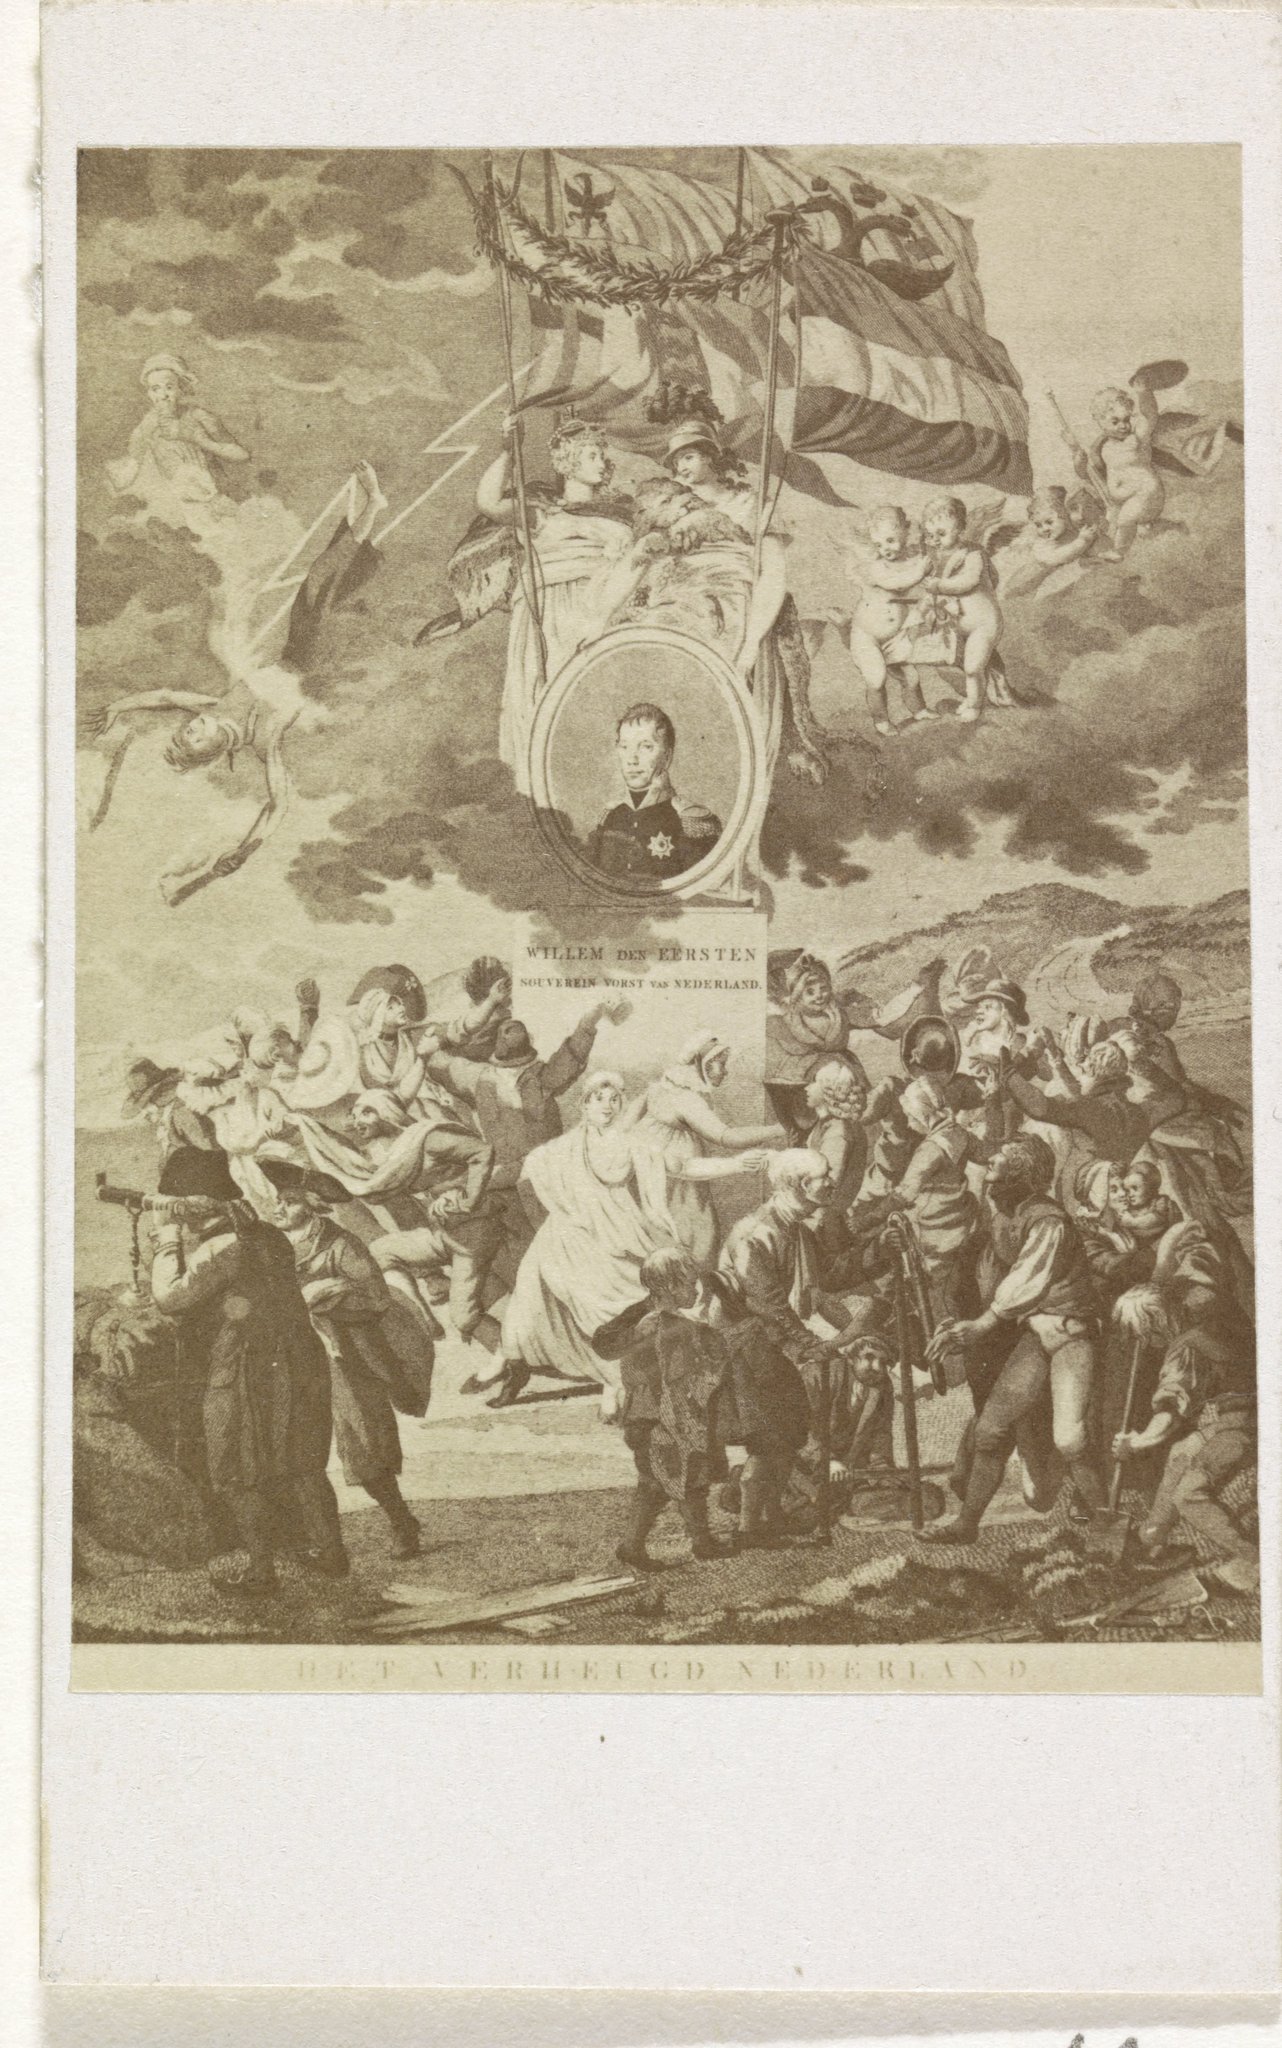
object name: photograph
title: Willem I, soeverein vorst der Nederlanden, 1814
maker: Anonymous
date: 1865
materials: cardboard, photographic support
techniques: photography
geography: netherlands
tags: the hague, berlin, william i of the netherlands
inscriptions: inscription: ‘den weled. Heer Fredr. Muller, van den uitgever J. Leendertz.’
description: Foto van een prent met een allegorie op de vrede en de aanstelling van prins Willem Frederik als soeverein vorst der Nederlanden, 30 maart 1814.